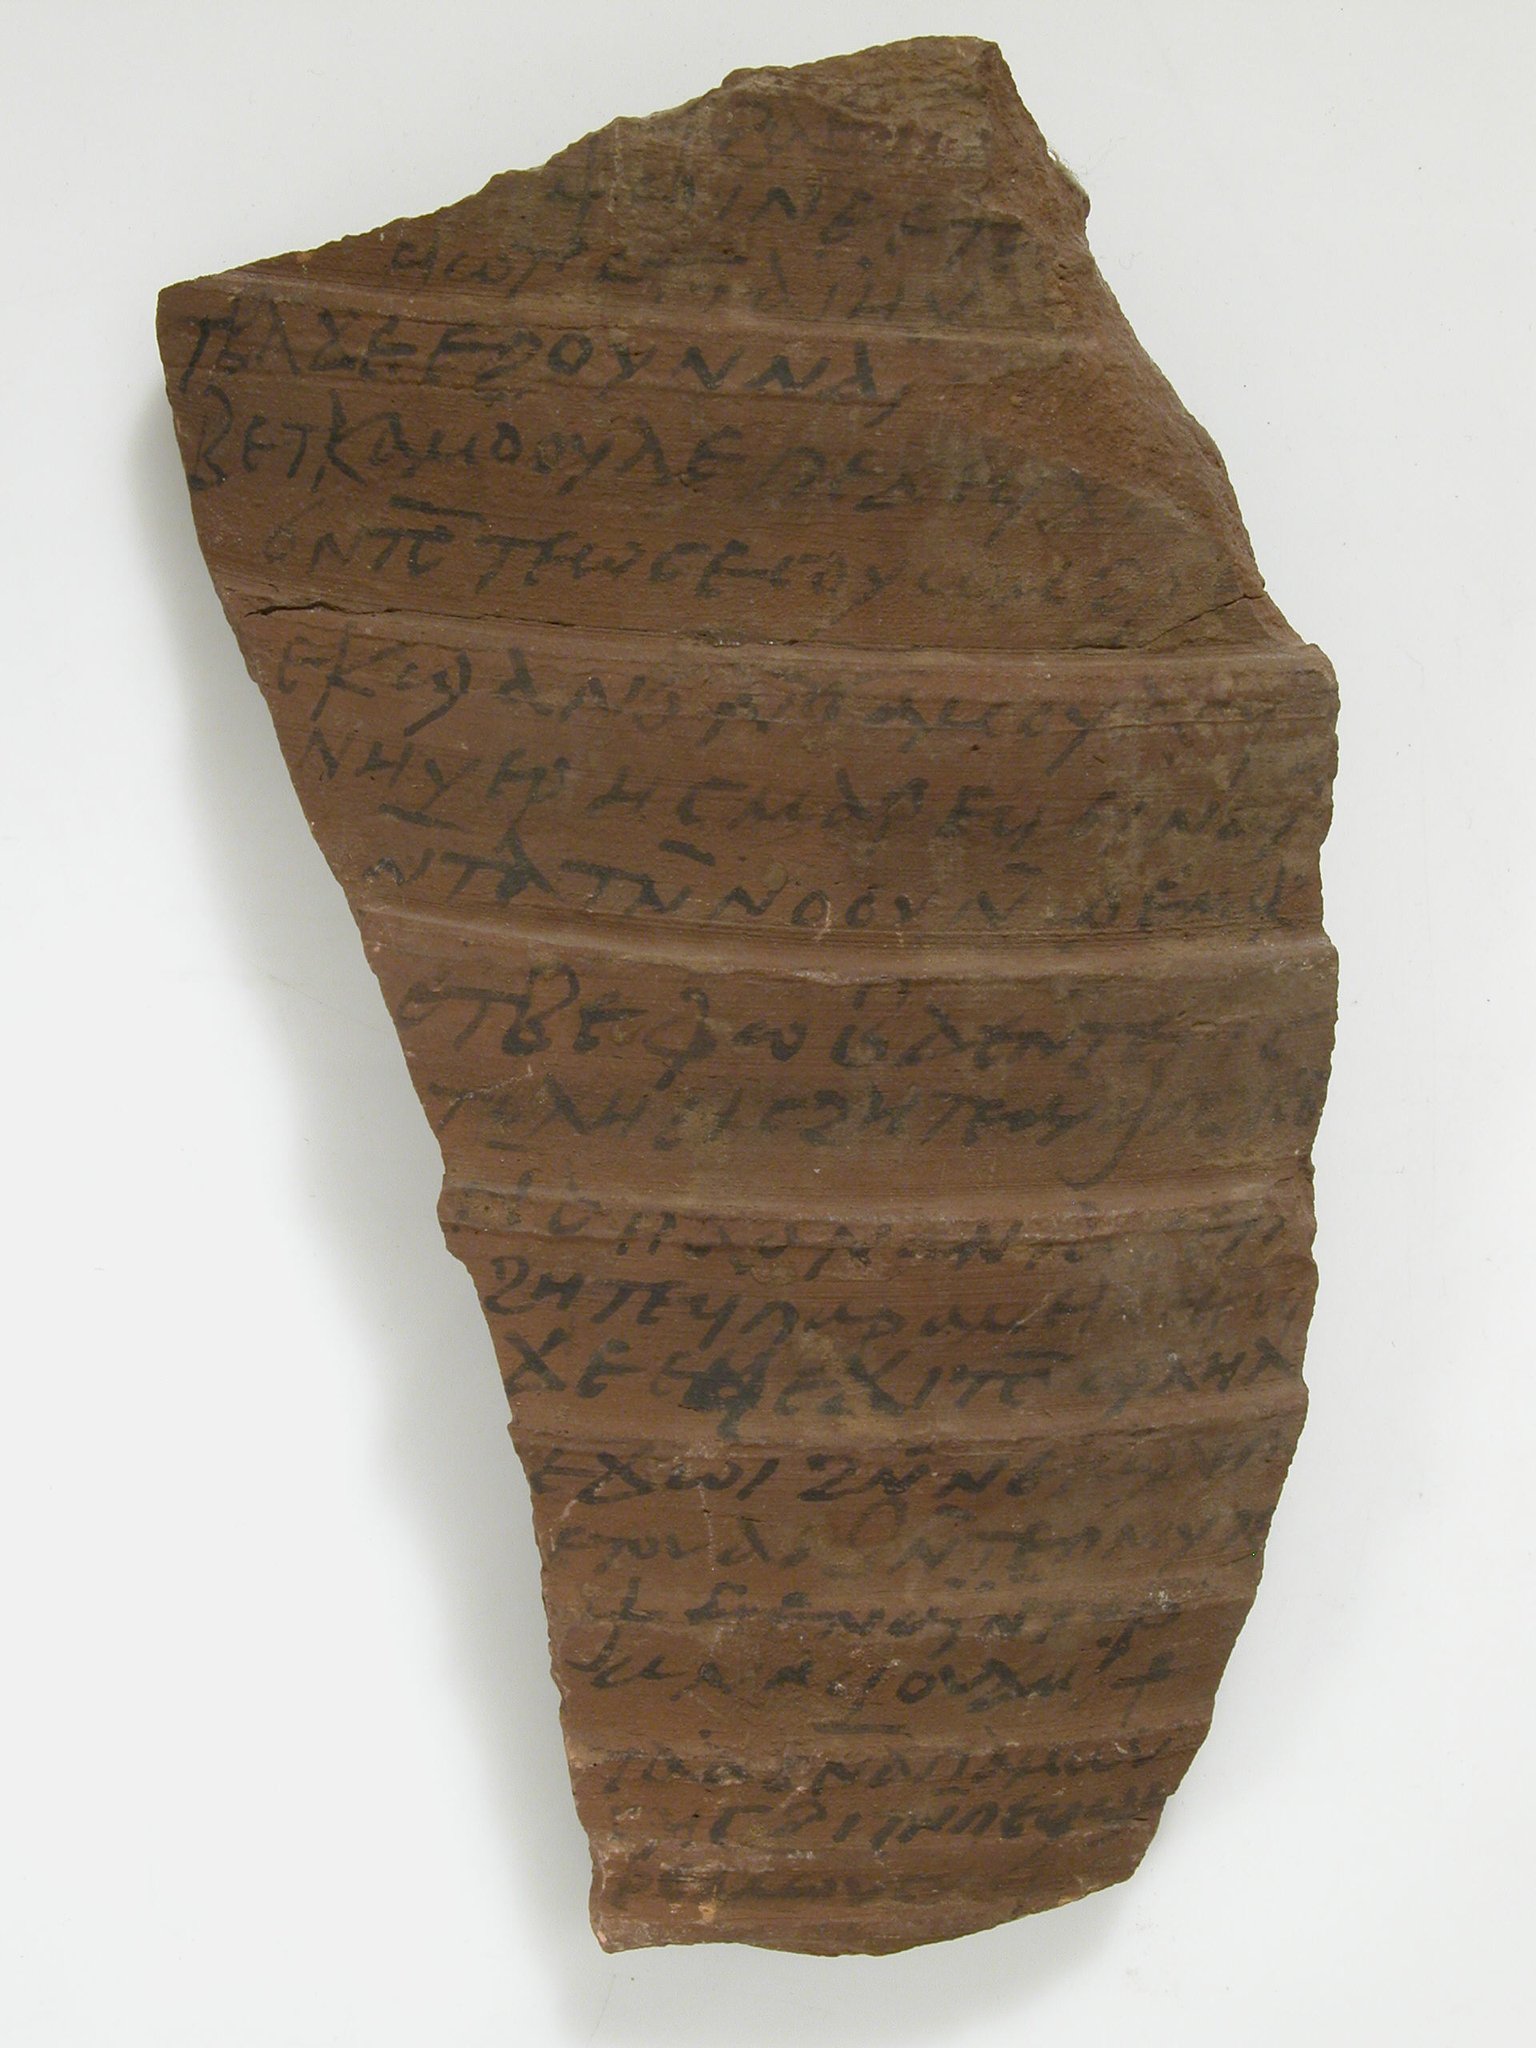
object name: ostrakon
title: Ostrakon with a Letter from Moses to Moses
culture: coptic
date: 601-700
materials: ink, pottery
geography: egypt